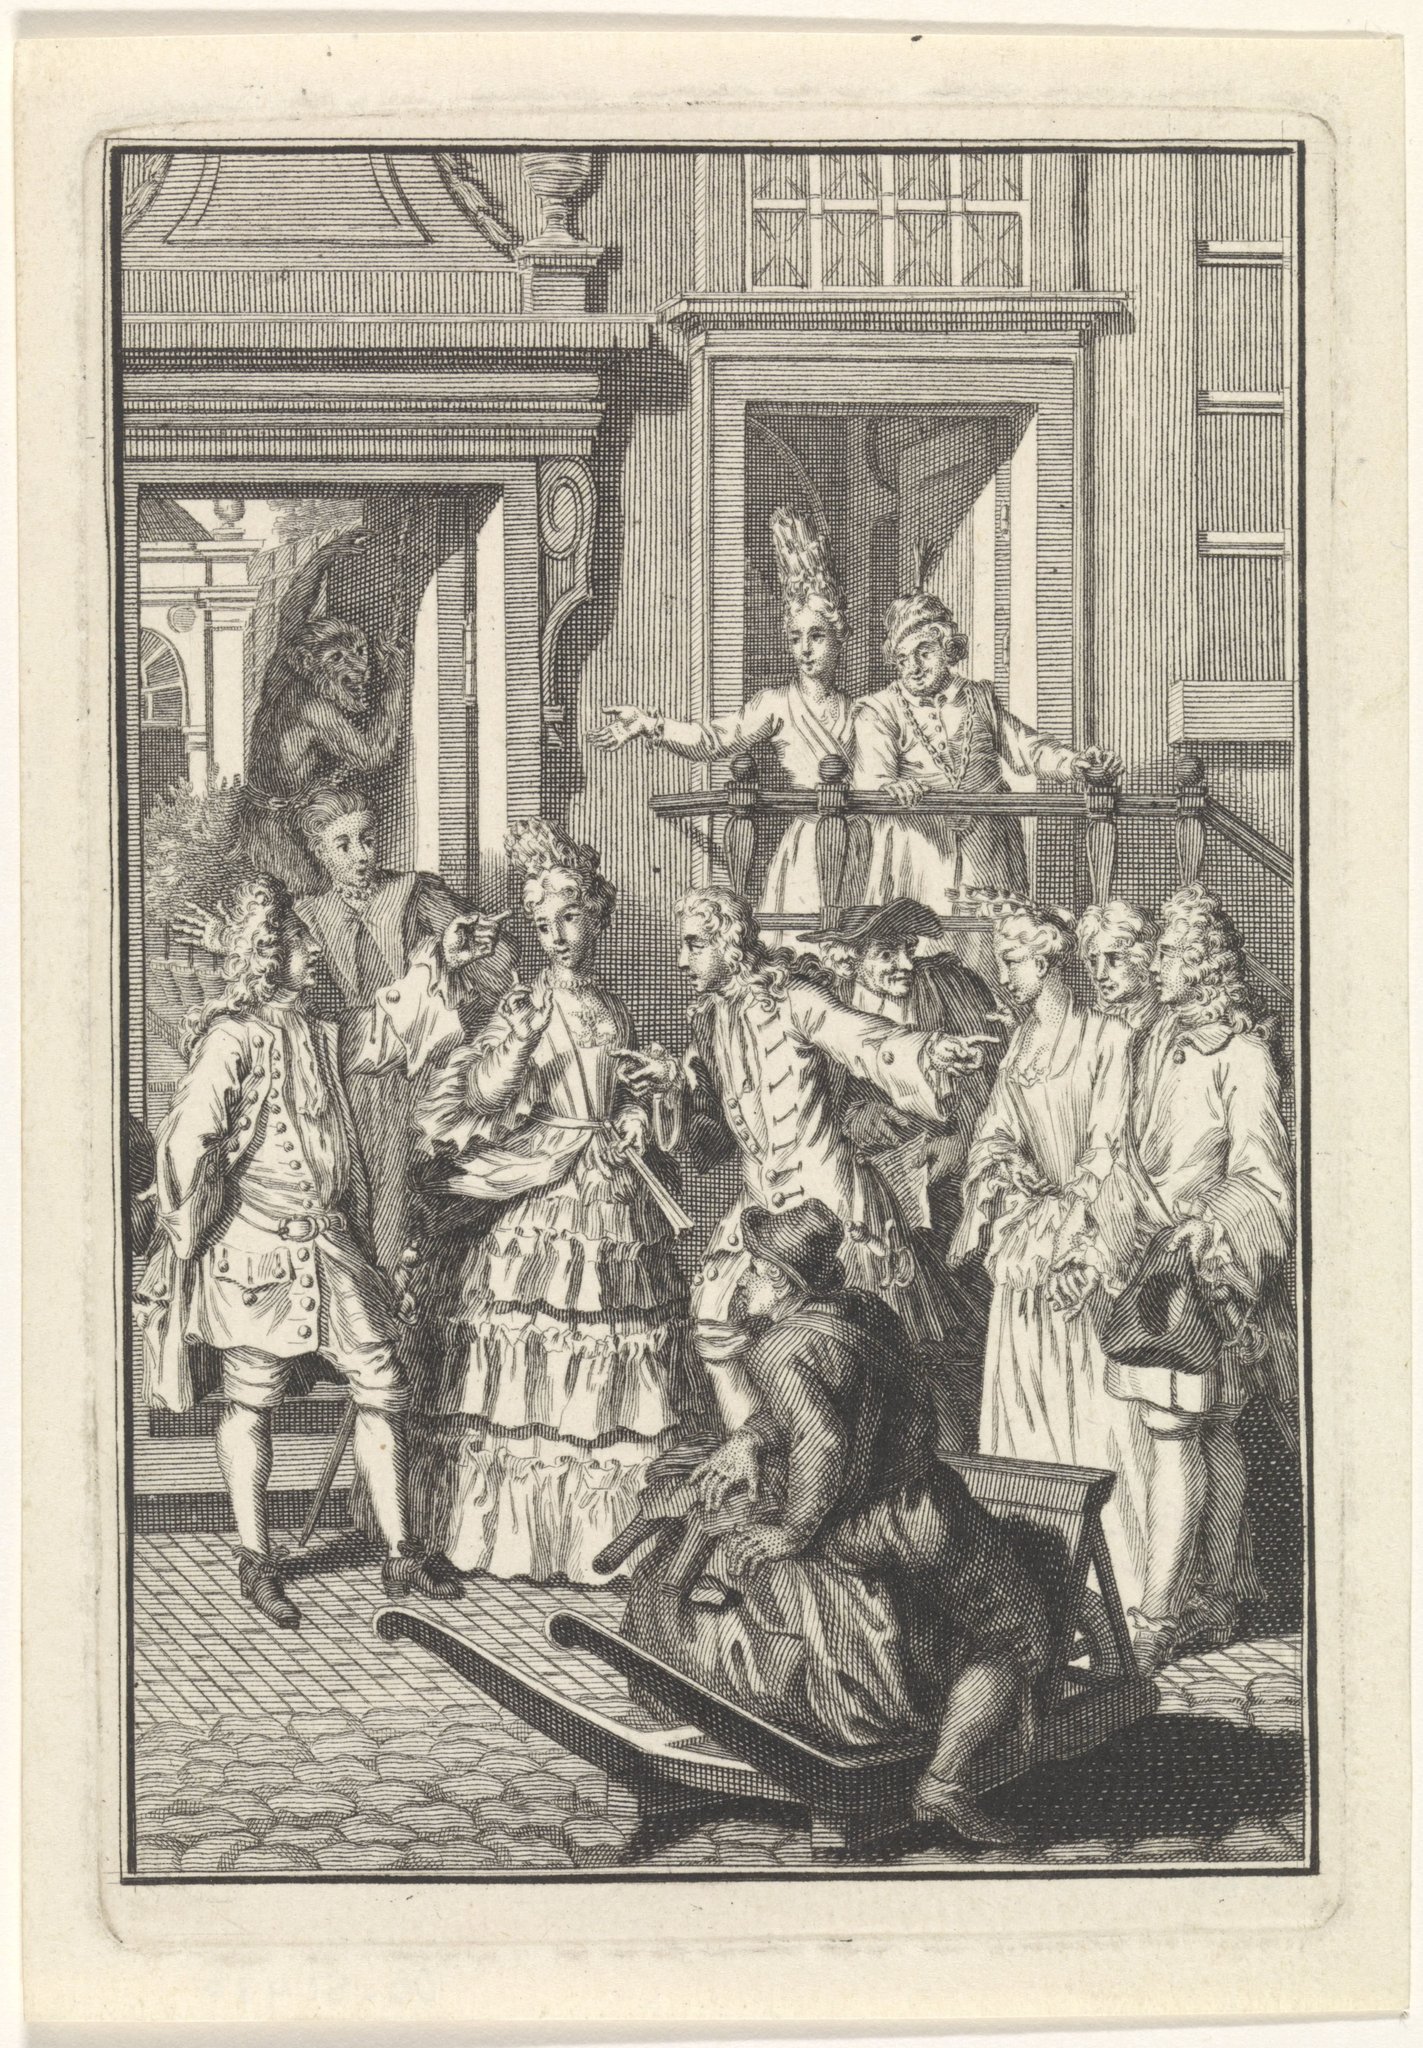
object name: print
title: Toneelscène uit een komedie met een elegant gezelschap op straat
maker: bernard picart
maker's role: draughtsman, print maker, publisher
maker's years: 1673-1733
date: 1715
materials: paper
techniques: engraving, etching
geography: amsterdam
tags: theatre, theatrical performance, beasts of prey, predatory animals: lion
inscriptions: collector's mark: Lugt 240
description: Een elegant gezelschap heeft zich op straat voor een huis verzameld. Twee mannen voeren geagiteerd een gesprek in het nabij zijn van een vrouw. Links op de achtergrond een leeuw die over een muur de tuin van het huis probeert in te klimmen.